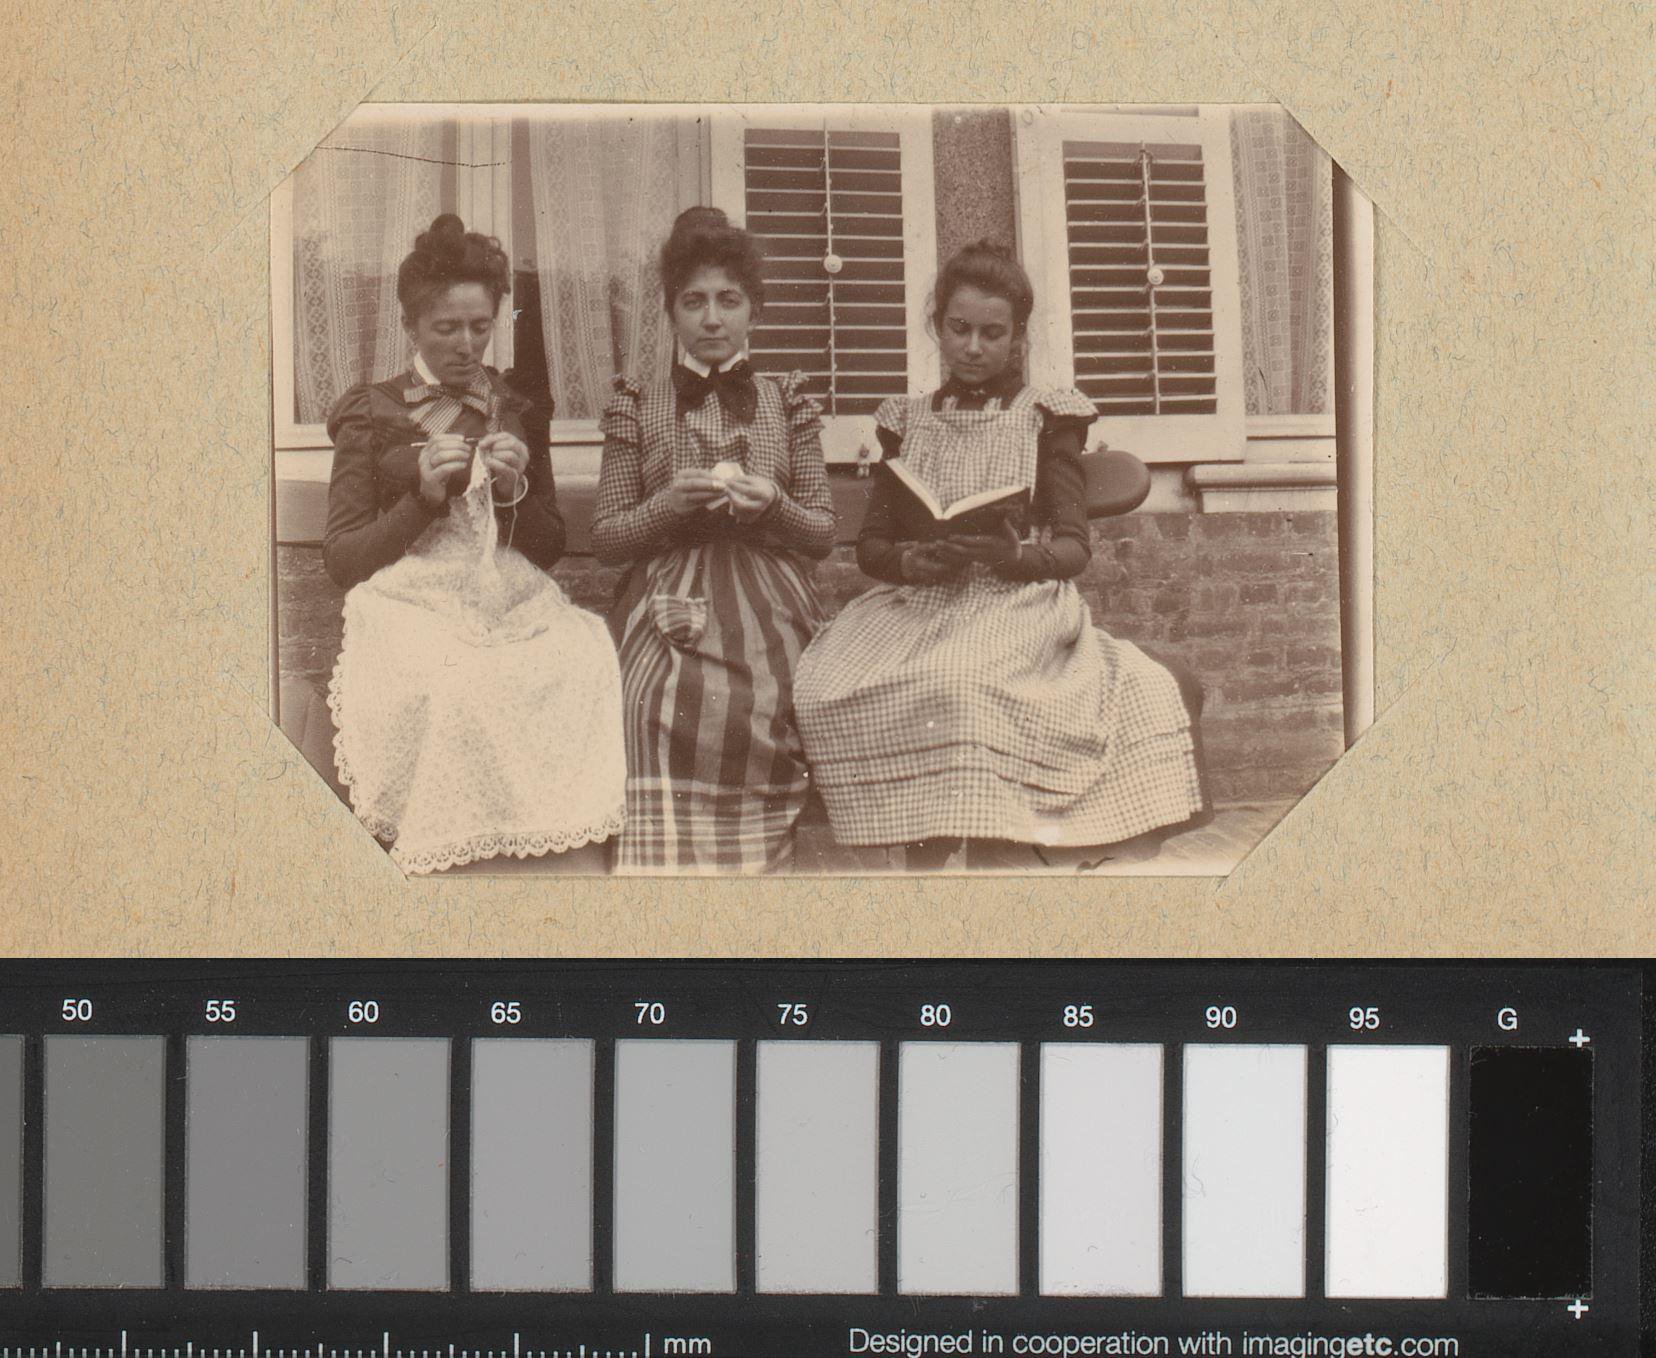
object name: photograph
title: Groepsportret van drie vrouwen, breiend en lezend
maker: Anonymous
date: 1897-1900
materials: paper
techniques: gelatin silver print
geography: france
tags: adolescent, young woman, maiden, adult woman, reading, historical persons not known by name - bb - woman, (other forms of) needlework, e.g.: crocheting, knitting, embroidering, france